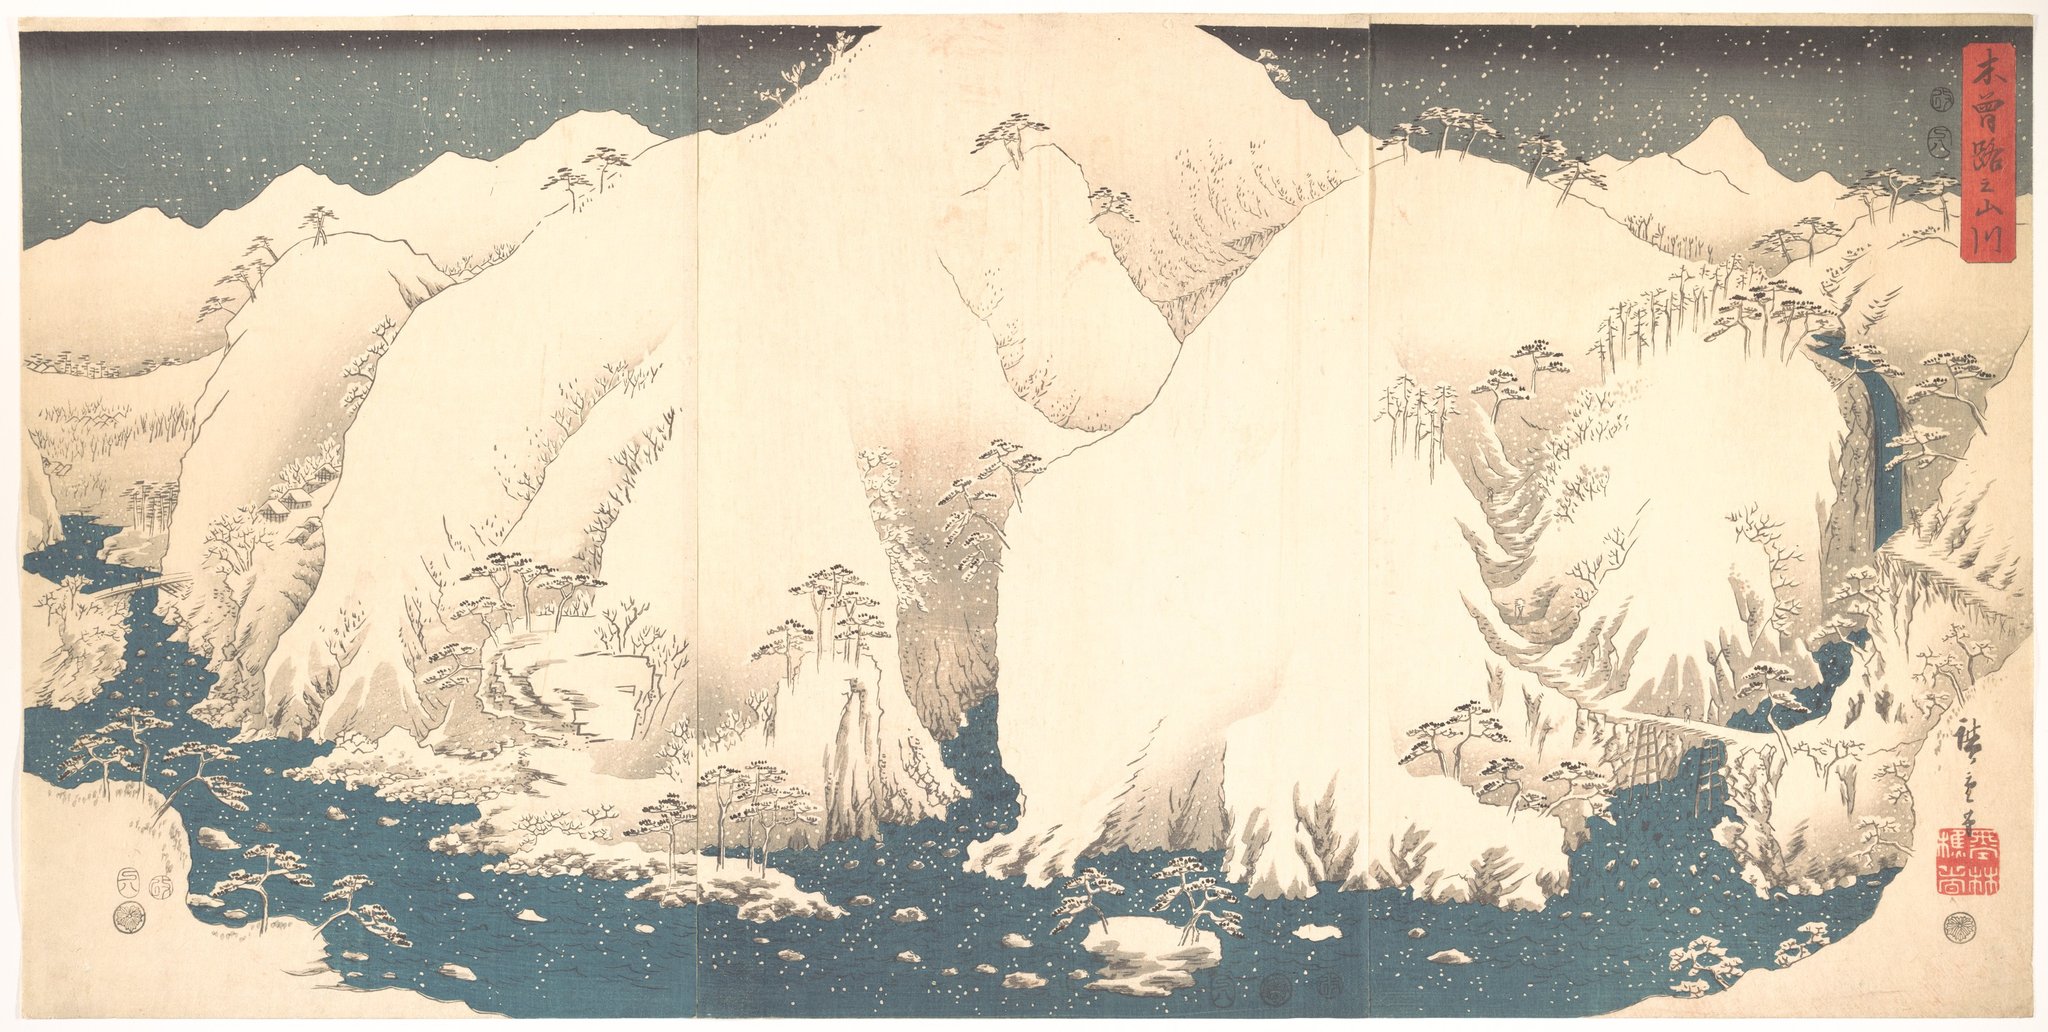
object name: woodblock print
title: Kisō Mountains in Snow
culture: japanese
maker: utagawa hiroshige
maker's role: artist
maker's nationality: japanese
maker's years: 1797-1858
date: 1857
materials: ink, paper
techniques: woodblock print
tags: mountains,snow